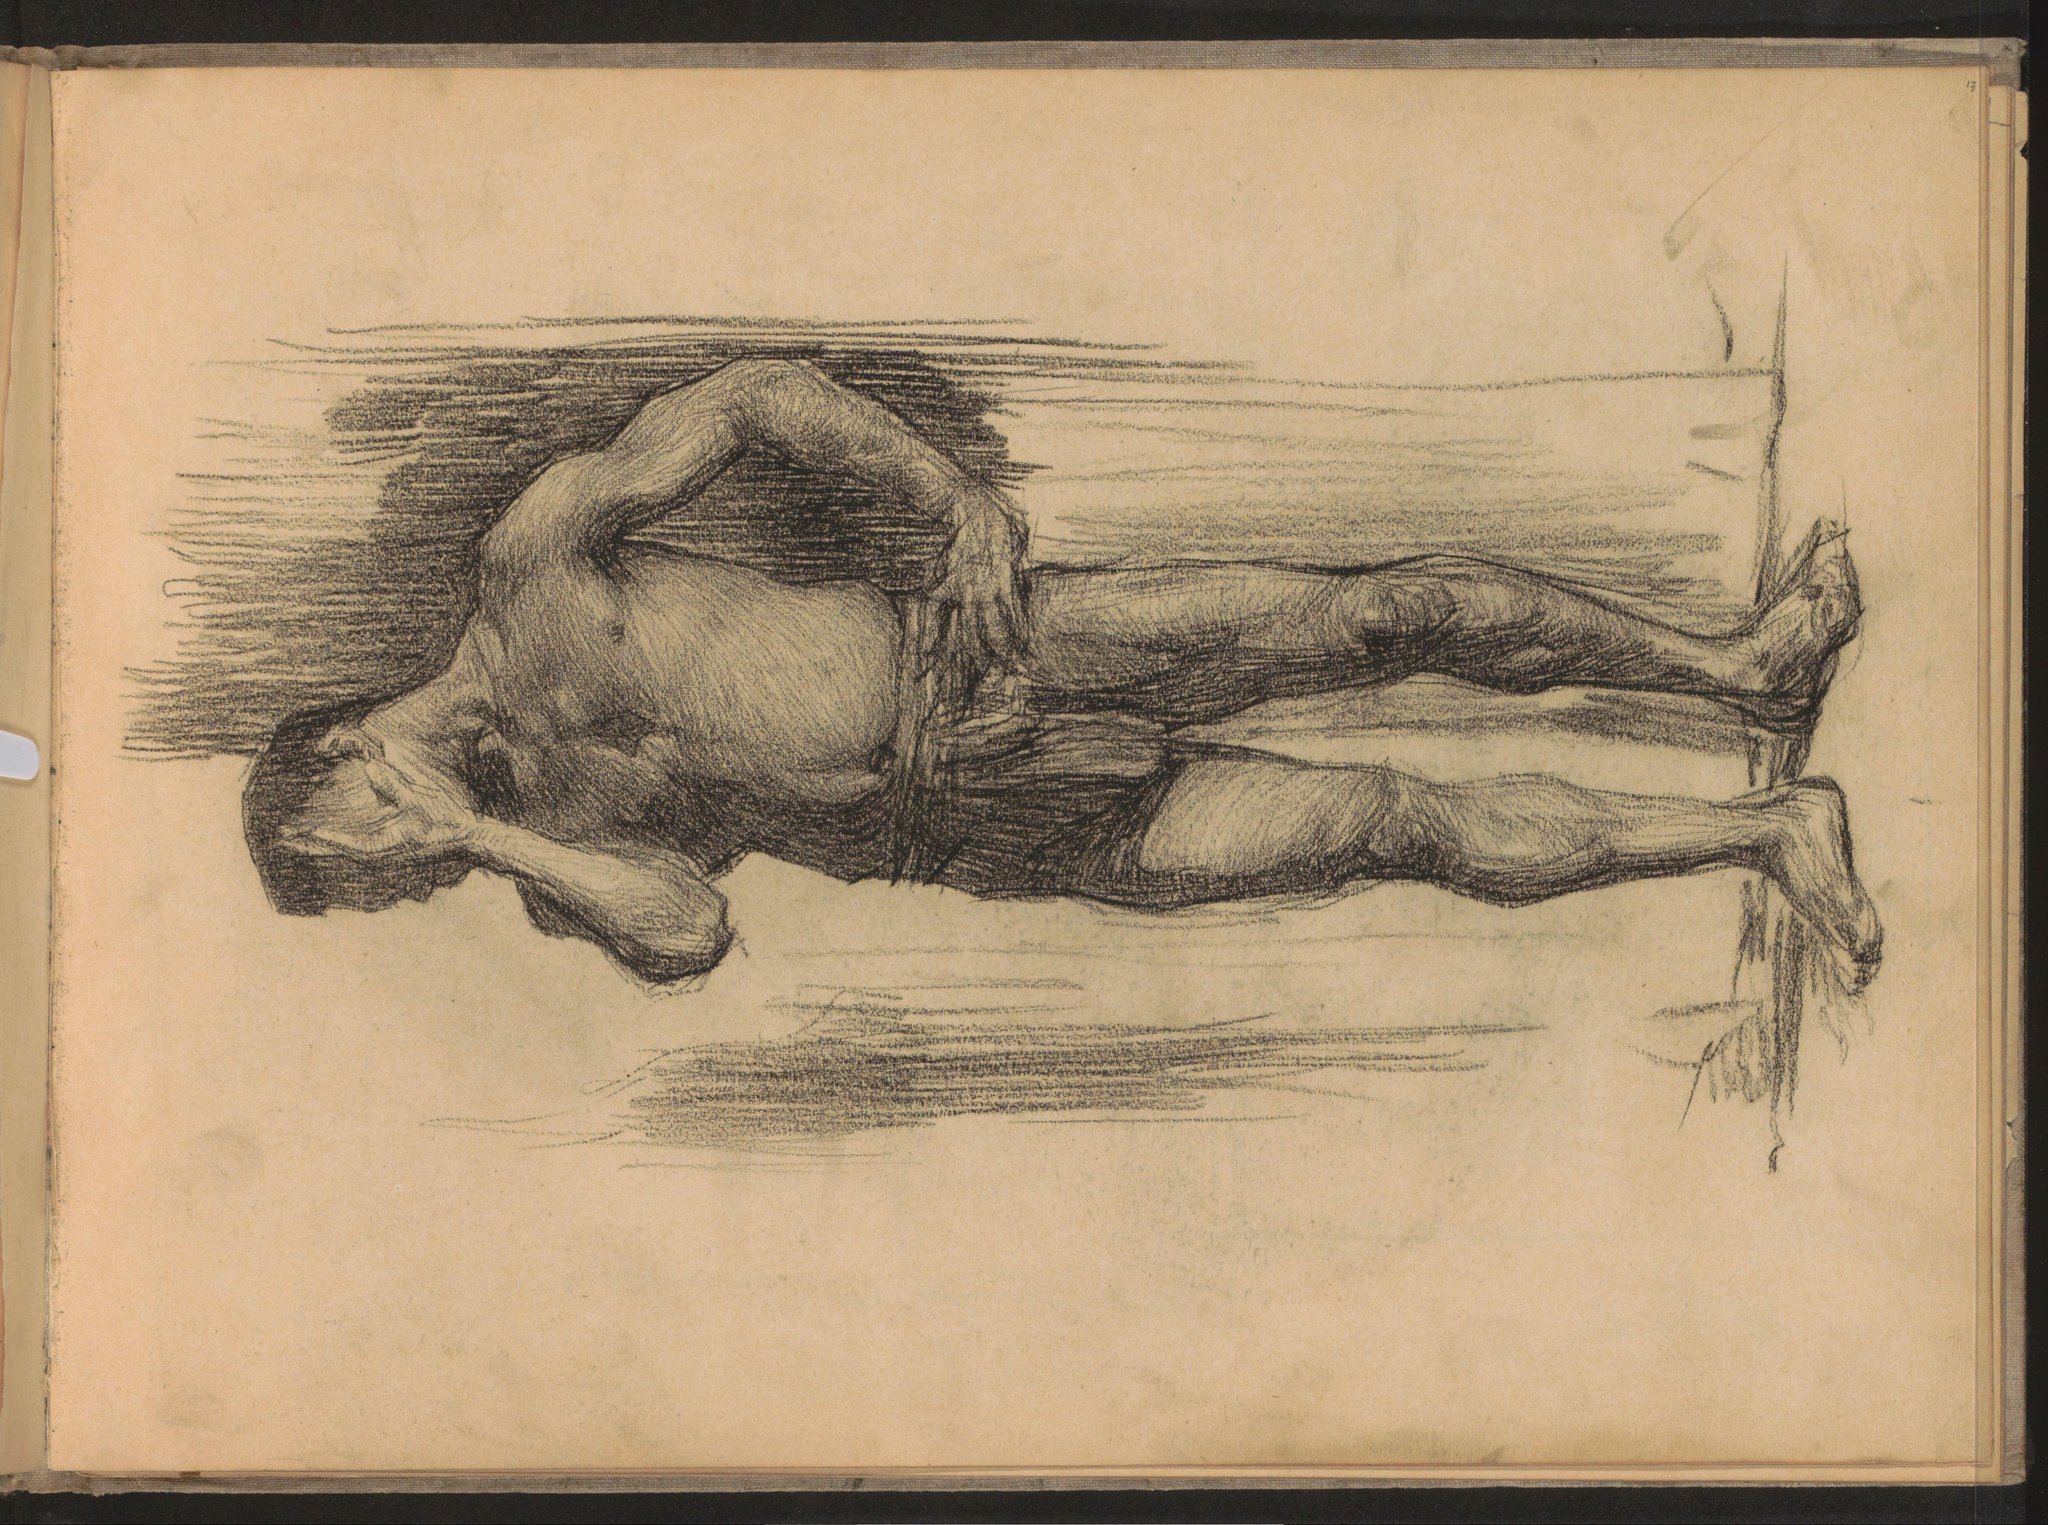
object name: sketchbook leaf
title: Staande naakte man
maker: marius bauer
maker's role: draughtsman, print maker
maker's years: 1867-1932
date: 1887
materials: chalk, paper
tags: standing figure, adult man, hand(s) bent towards the head, the (nude) human figure; 'corpo humano' (ripa) - aa - female human figure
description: De man is in vooraanzicht en ten voeten uit getekend. Zijn hand bedekt deels zijn gezicht. Pagina 17 uit een schetsboek met 19 bladen.